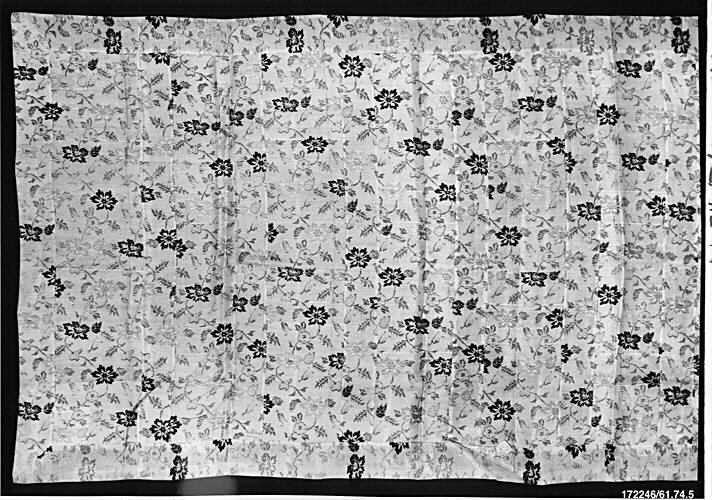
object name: robe, priest's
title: Priest's Robe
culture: japanese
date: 1701-1800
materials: metal thread, silk